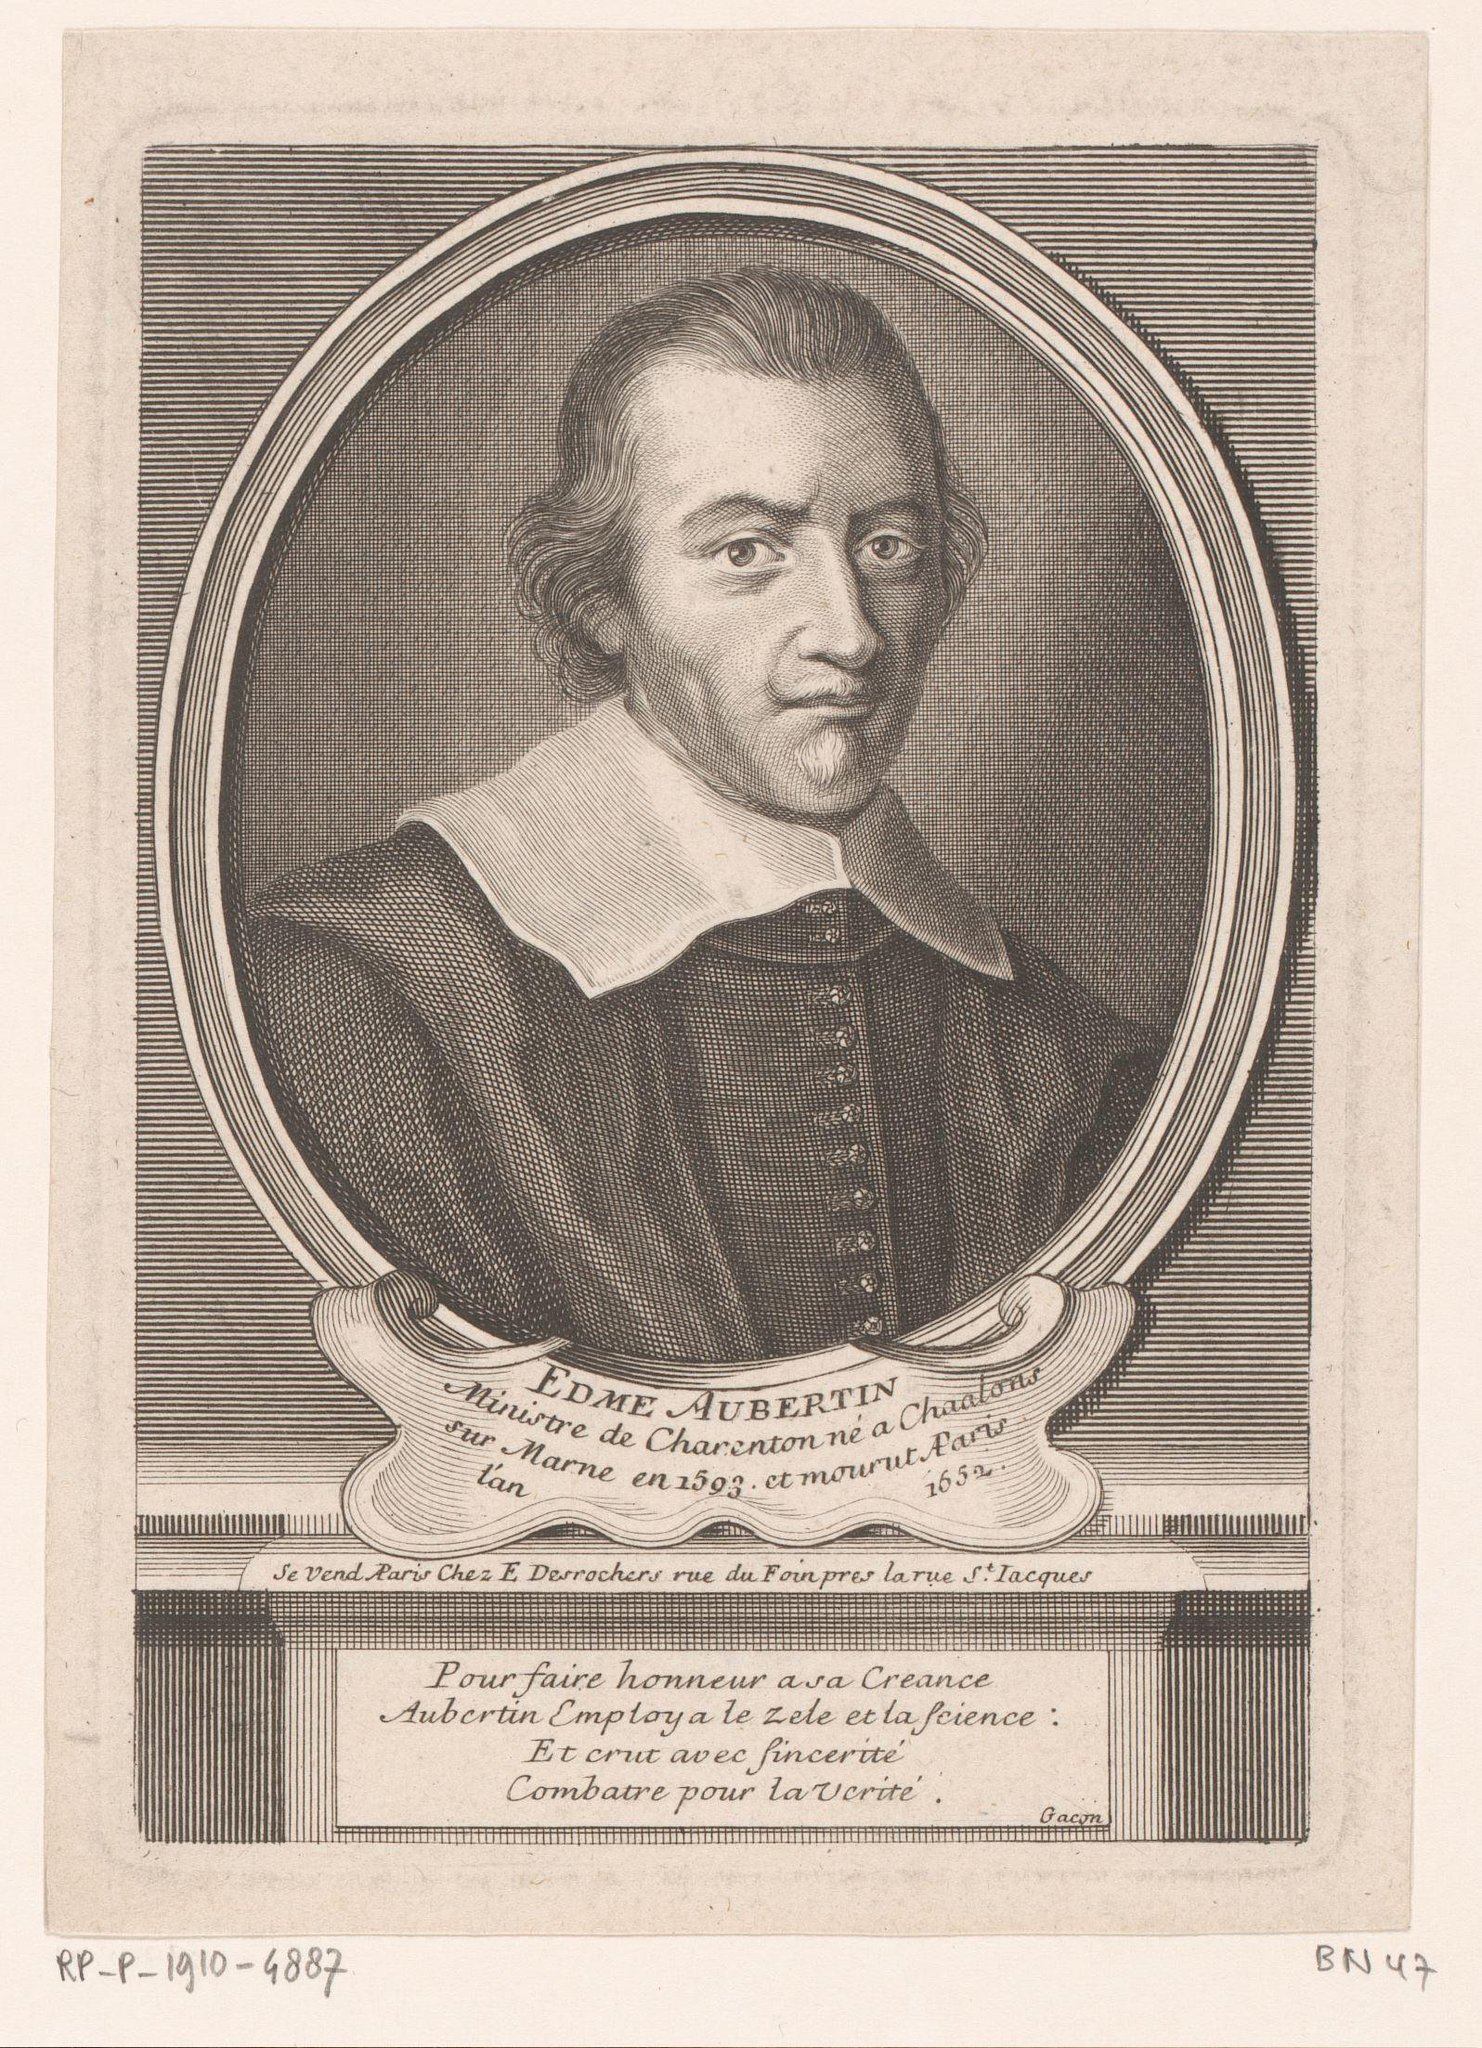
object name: print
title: Verzameling portretten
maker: étienne desrochers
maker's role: print maker, publisher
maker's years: 1668-1741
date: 1726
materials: paper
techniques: engraving, etching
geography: paris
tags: historical persons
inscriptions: collector's mark: Lugt 2228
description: Behoort waarschijnlijk tot een serie portretten, grotendeels door Etienne Desrochers, getiteld: 'Recueil de portraits de personnes qui se sont distinguées tant dans les Armes que dans Belles-Lettres et les Arts, comme aussi la famille royale de France et autres cours étrangères'. De serie werd initieel uitgegeven door Desrochers en aangekondigd in 'Mercure' in mei 1726, p. 985. Echter was Desrochers reeds enkele jaren eerder begonnen met het uitgeven van de serie. Na de dood van Desrochers werd de serie voortgezet door Gilles Edme Petit. Een latere staat werd uitgegeven door Jean François Daumont in Parijs.